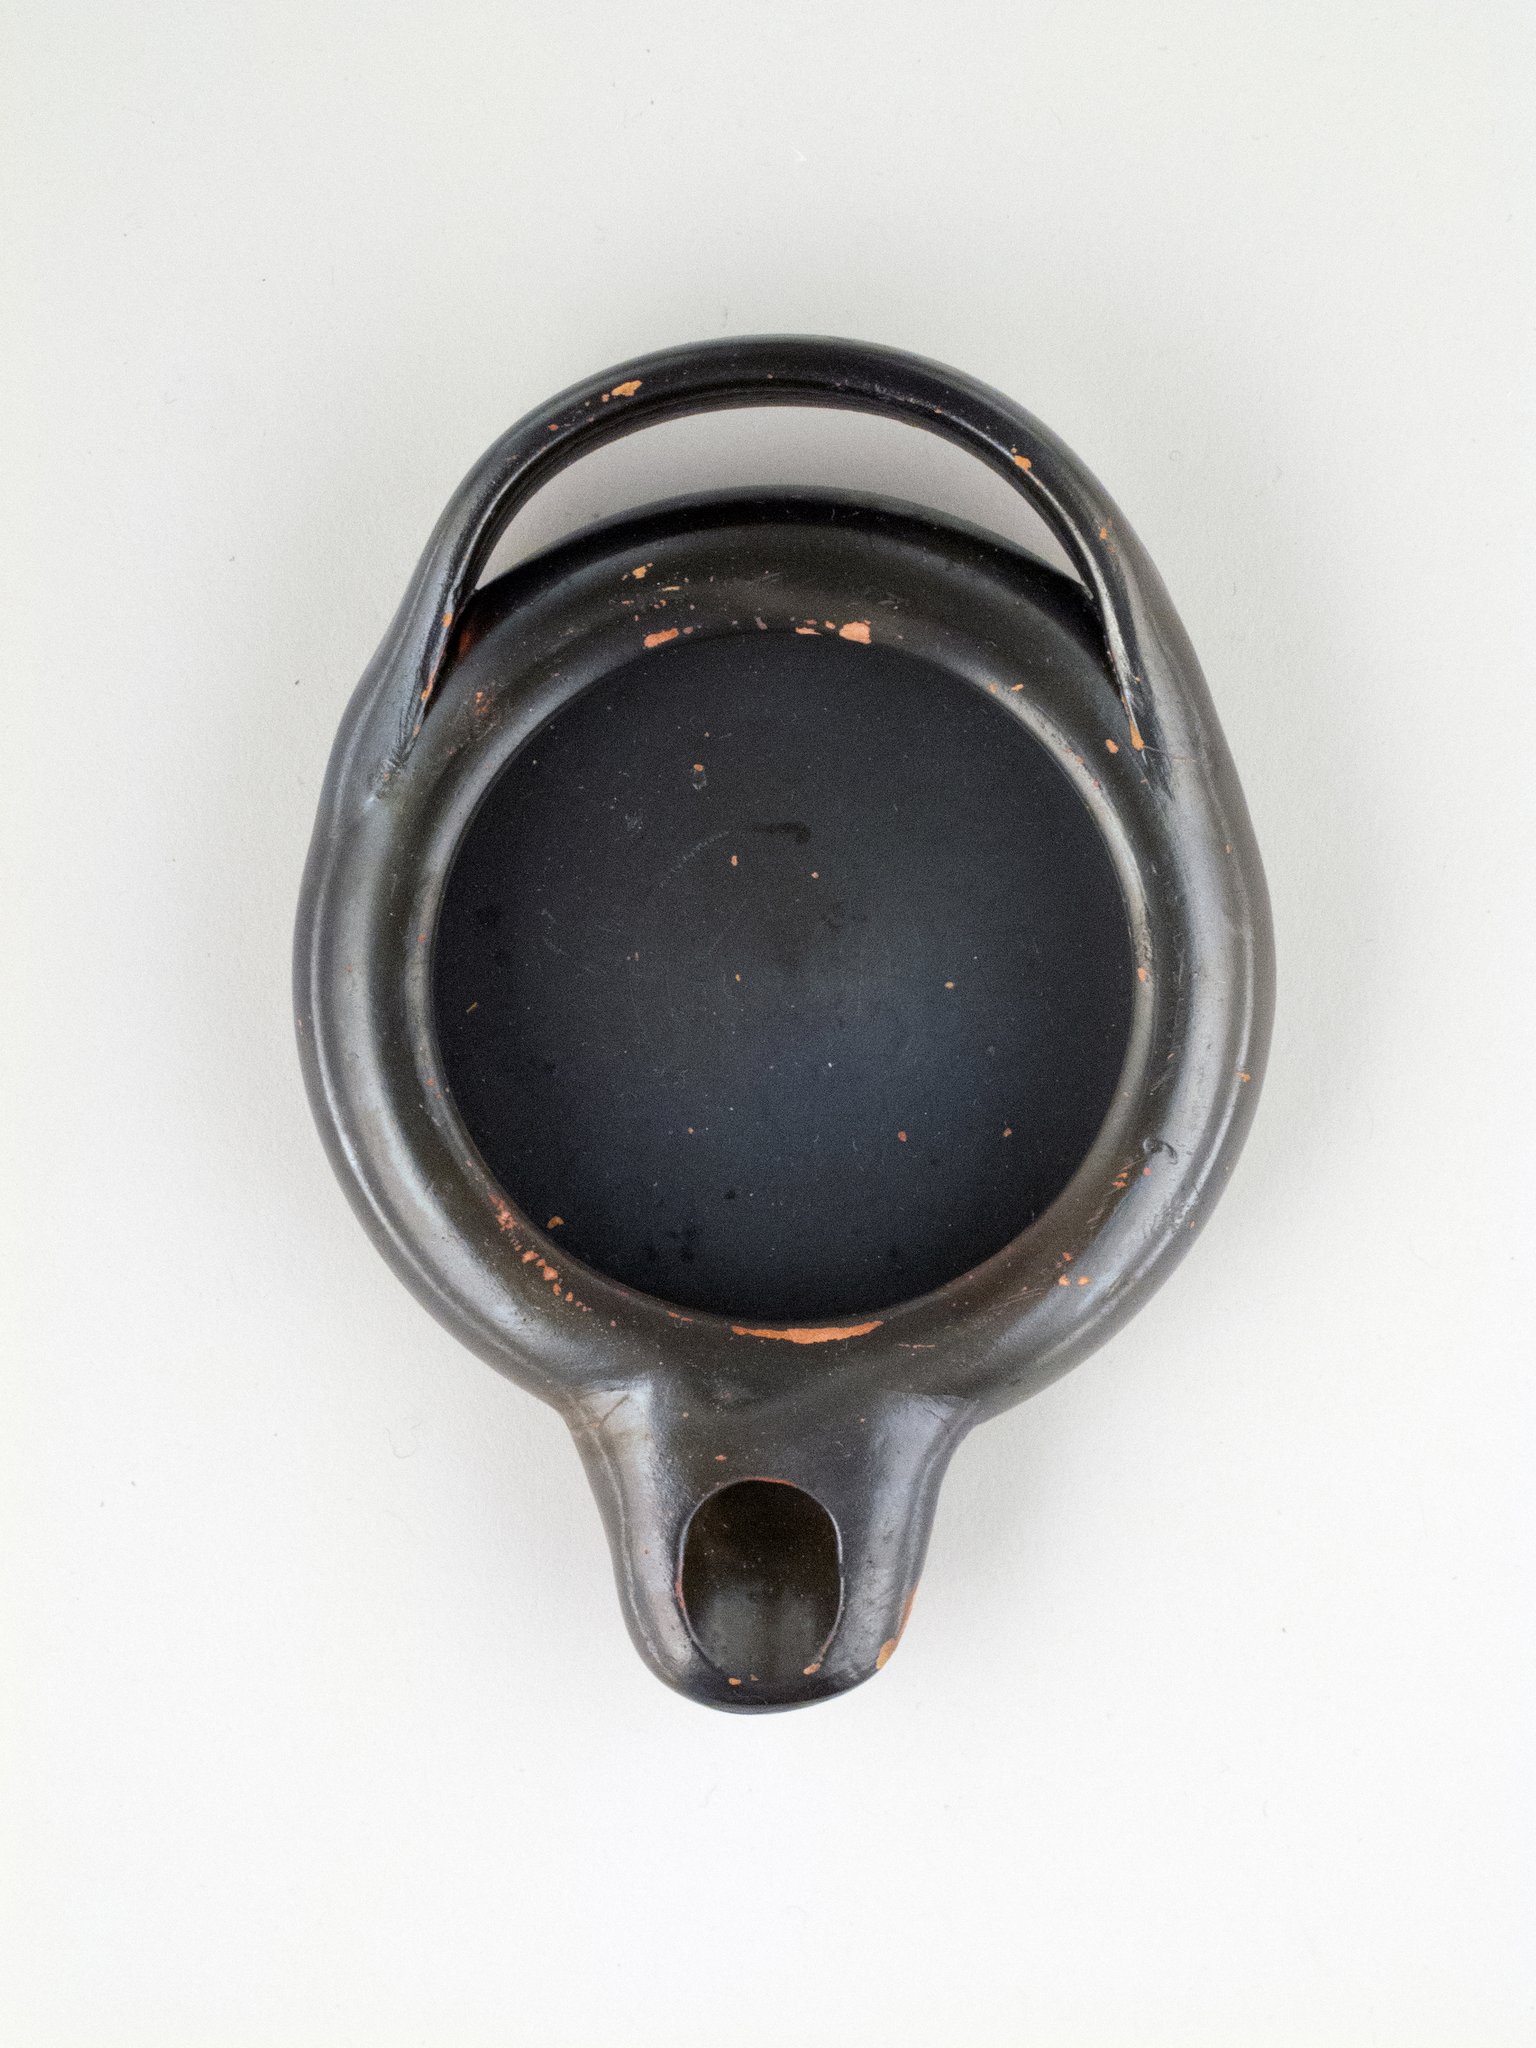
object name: lamp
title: Terracotta lamp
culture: greek, attic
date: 500-401 BCE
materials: terracotta